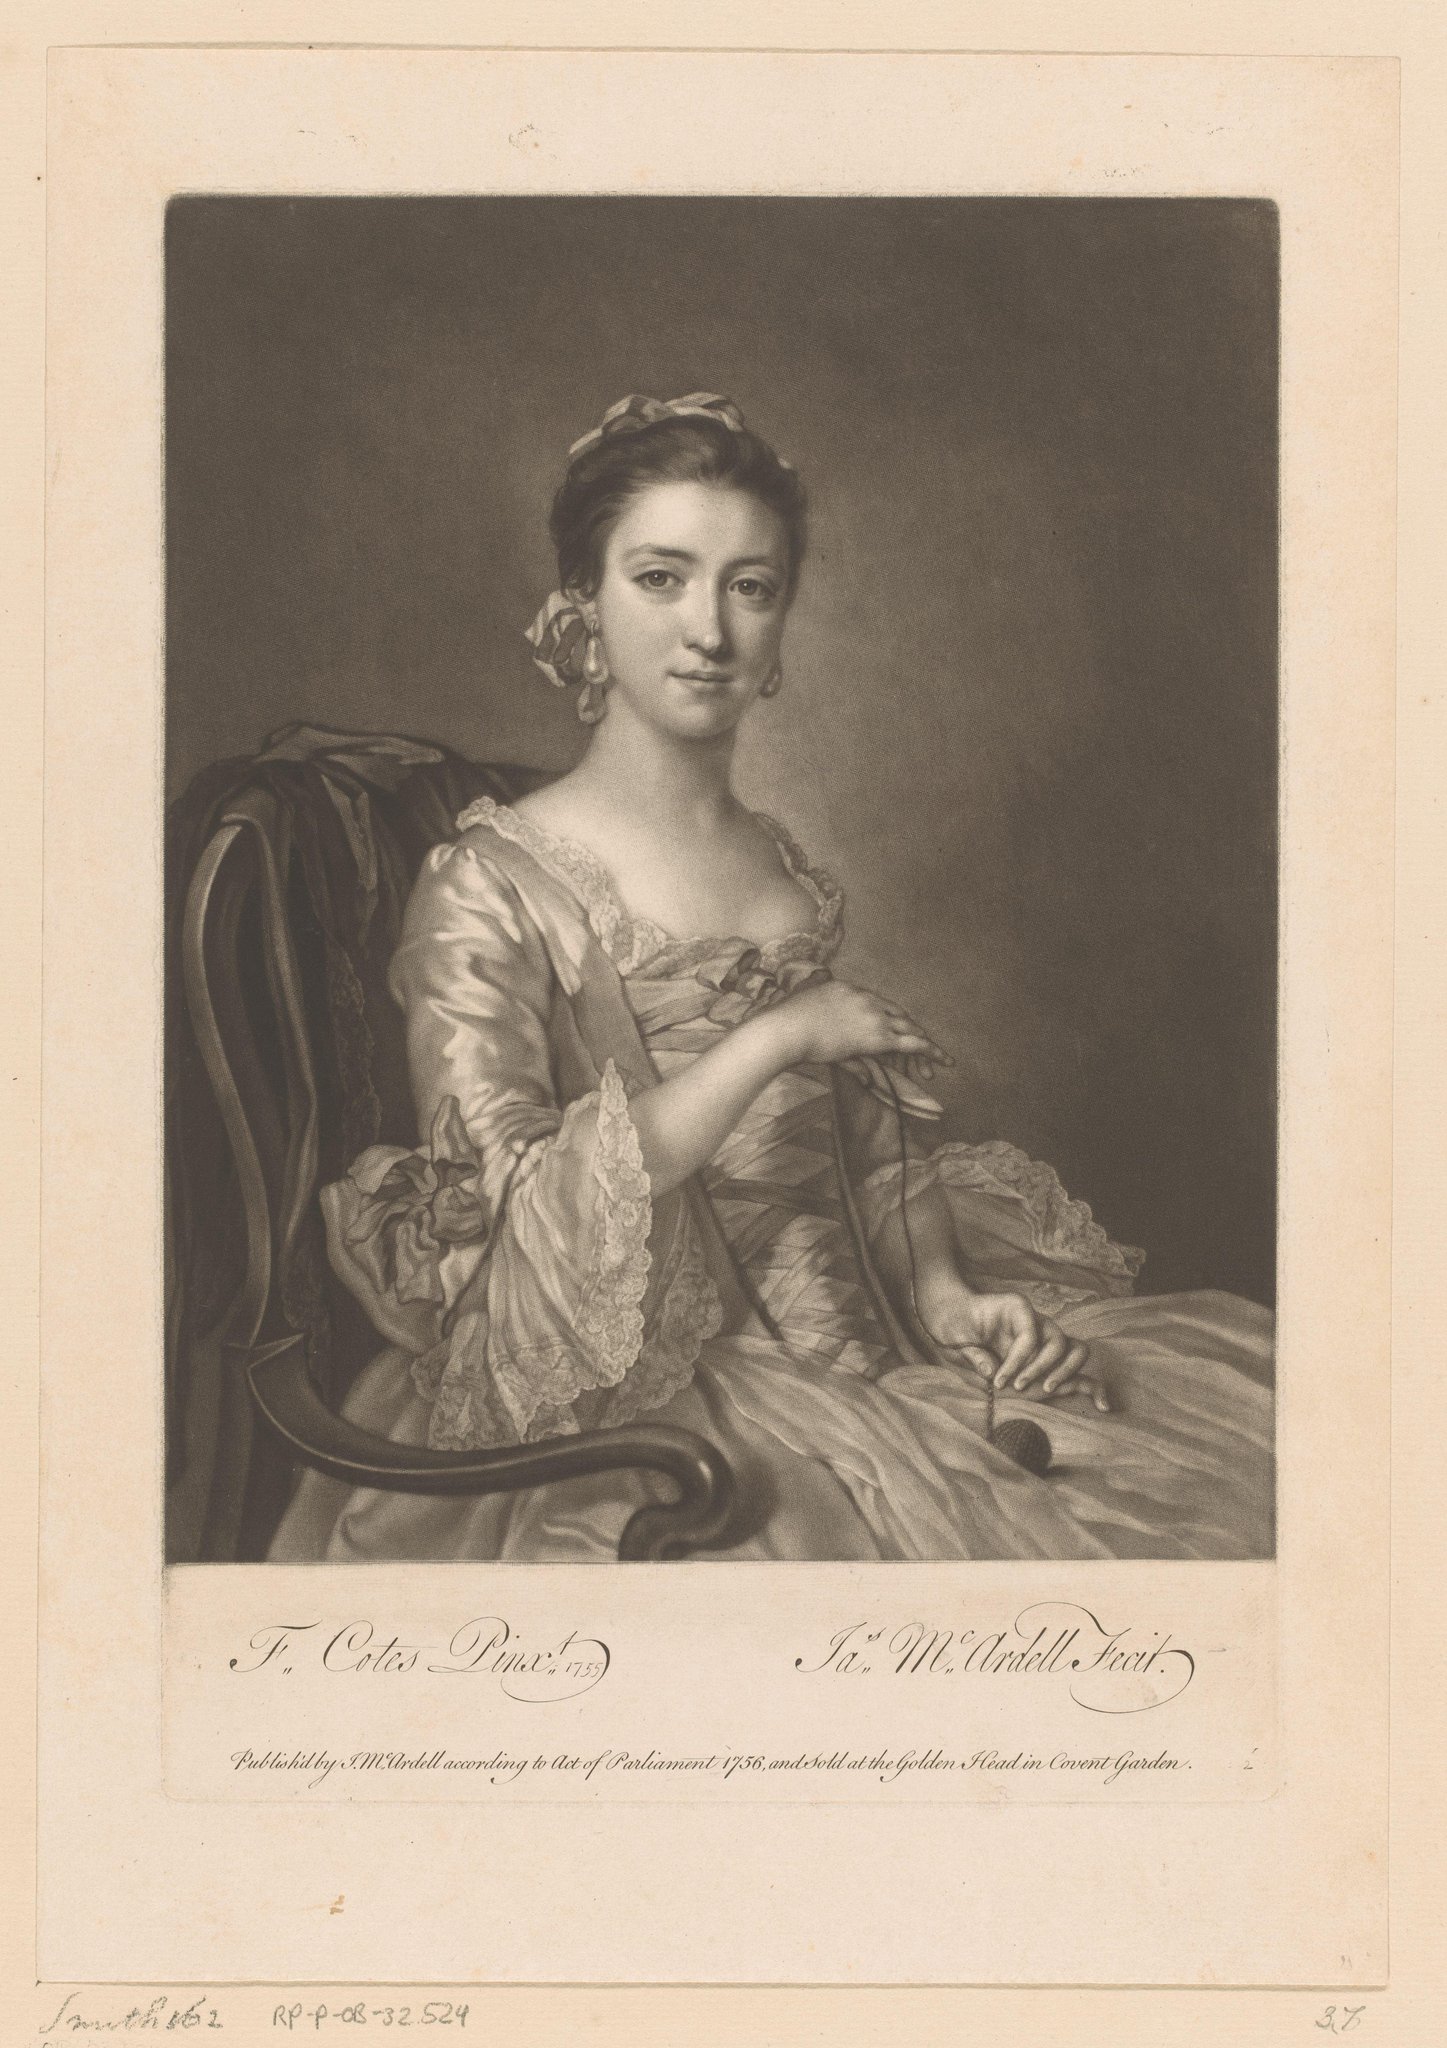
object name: print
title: Portret van Elizabeth Sandby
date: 1756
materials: paper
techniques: mezzotint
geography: london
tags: historical persons - bb - woman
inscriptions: collector's mark: Lugt 240